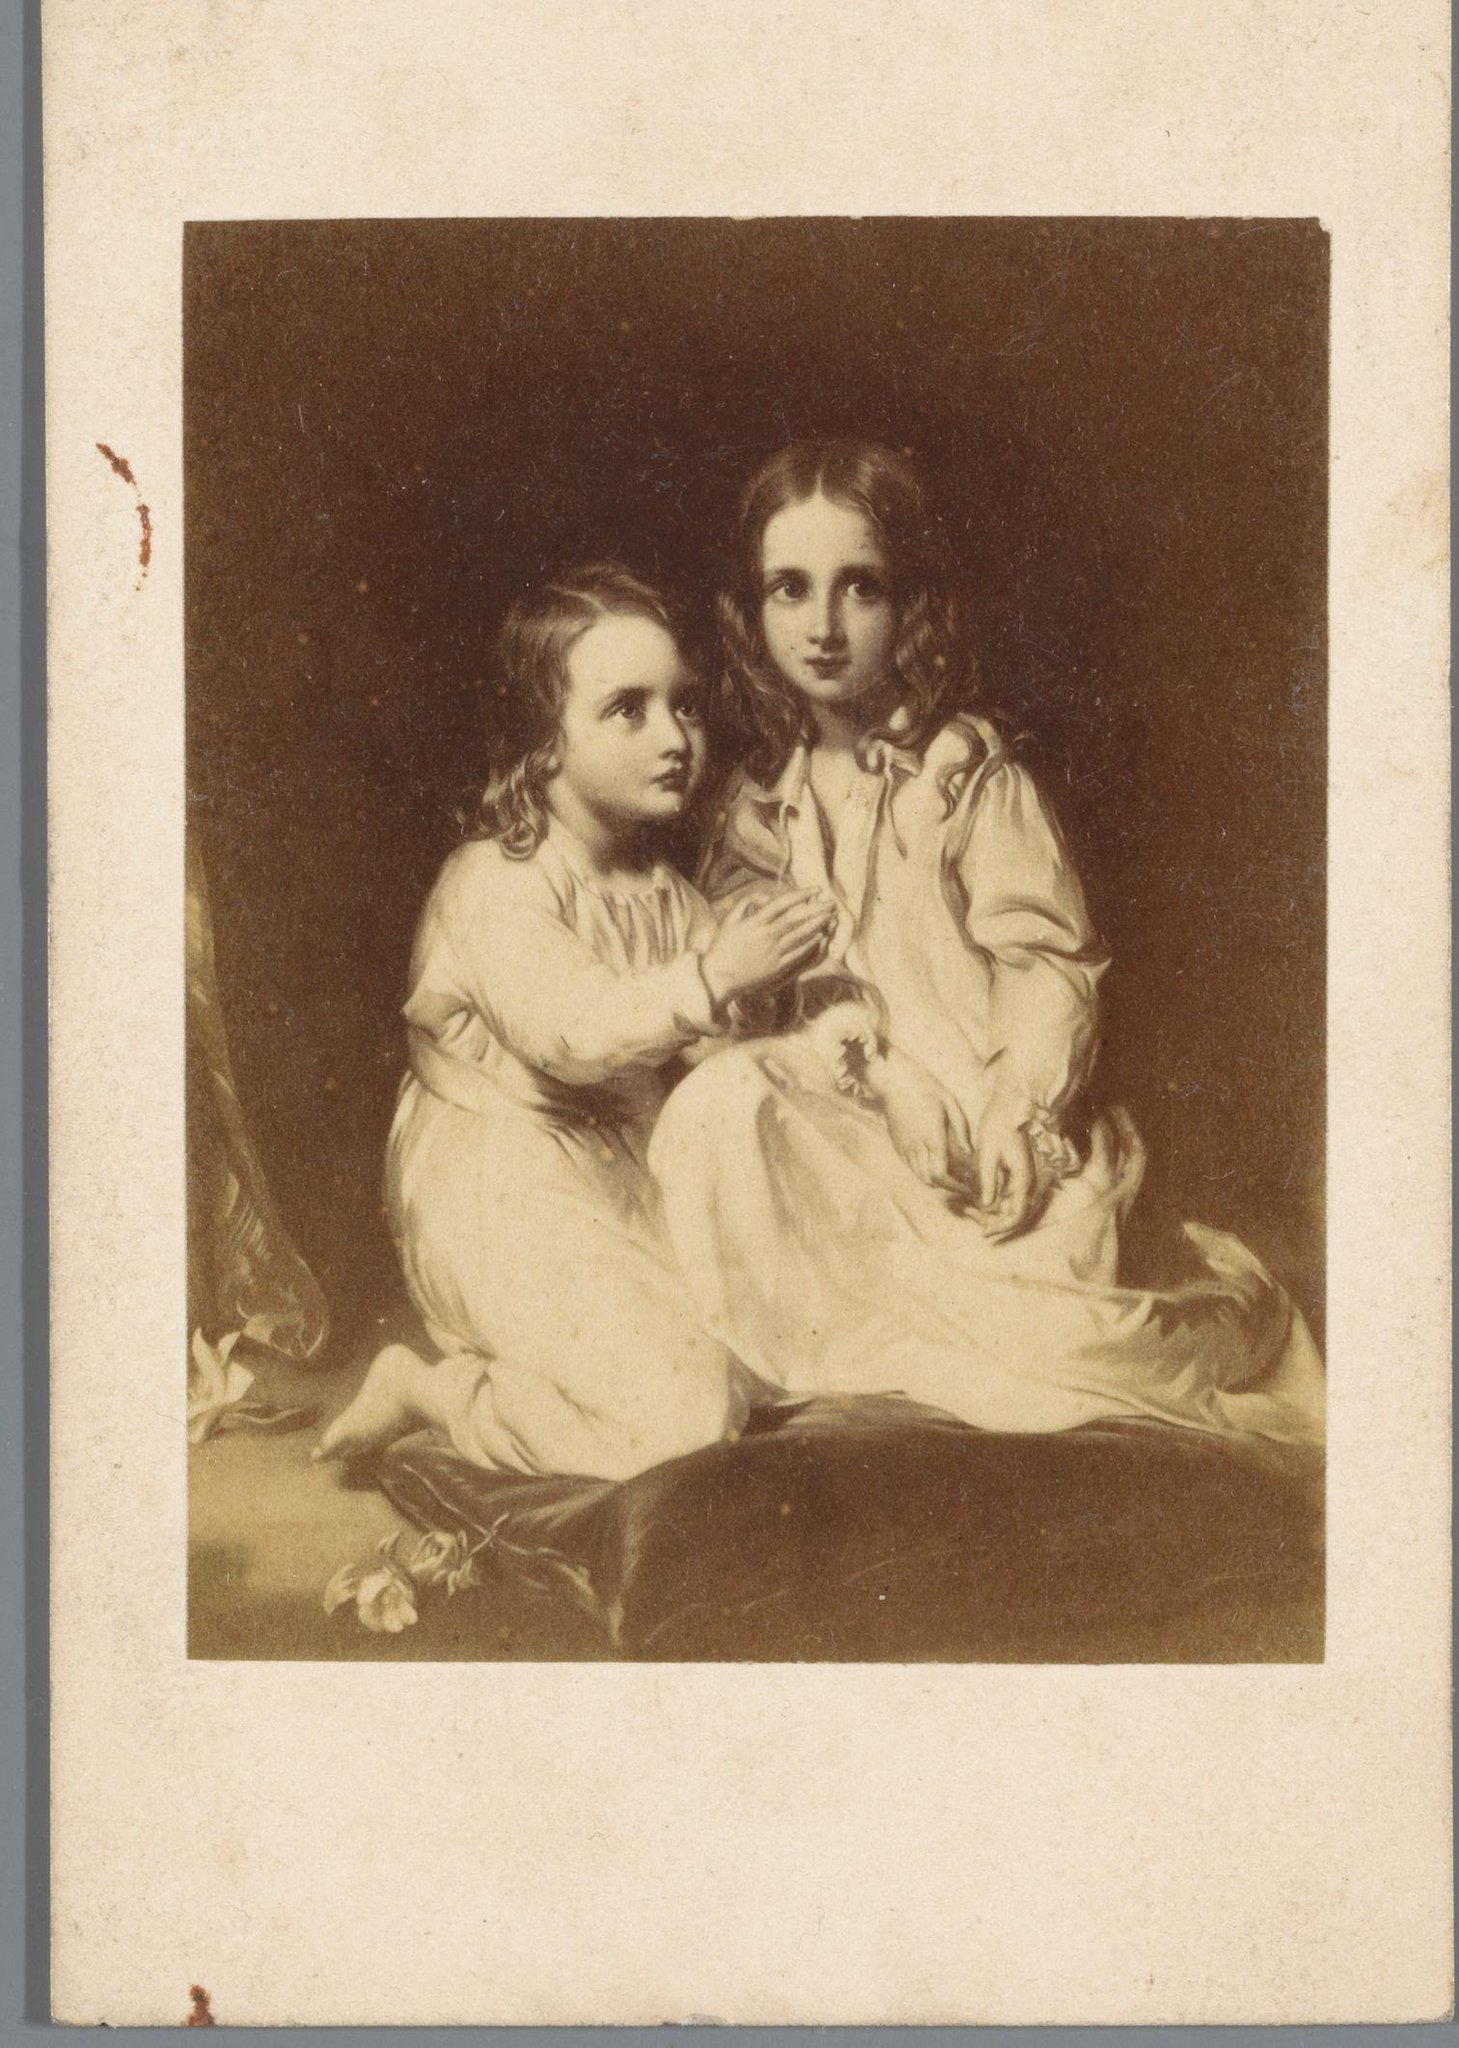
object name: carte de visite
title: Fotoreproductie van een schilderij naar het gedicht Kinderbede door J.J.L. ten Kate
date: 1850-1900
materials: cardboard, photographic support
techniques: albumen print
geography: amsterdam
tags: child (+ two persons)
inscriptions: inscription: ‘KINDERBEDE./ (...) "Amen."/ J. J. L. TEN KATE.’